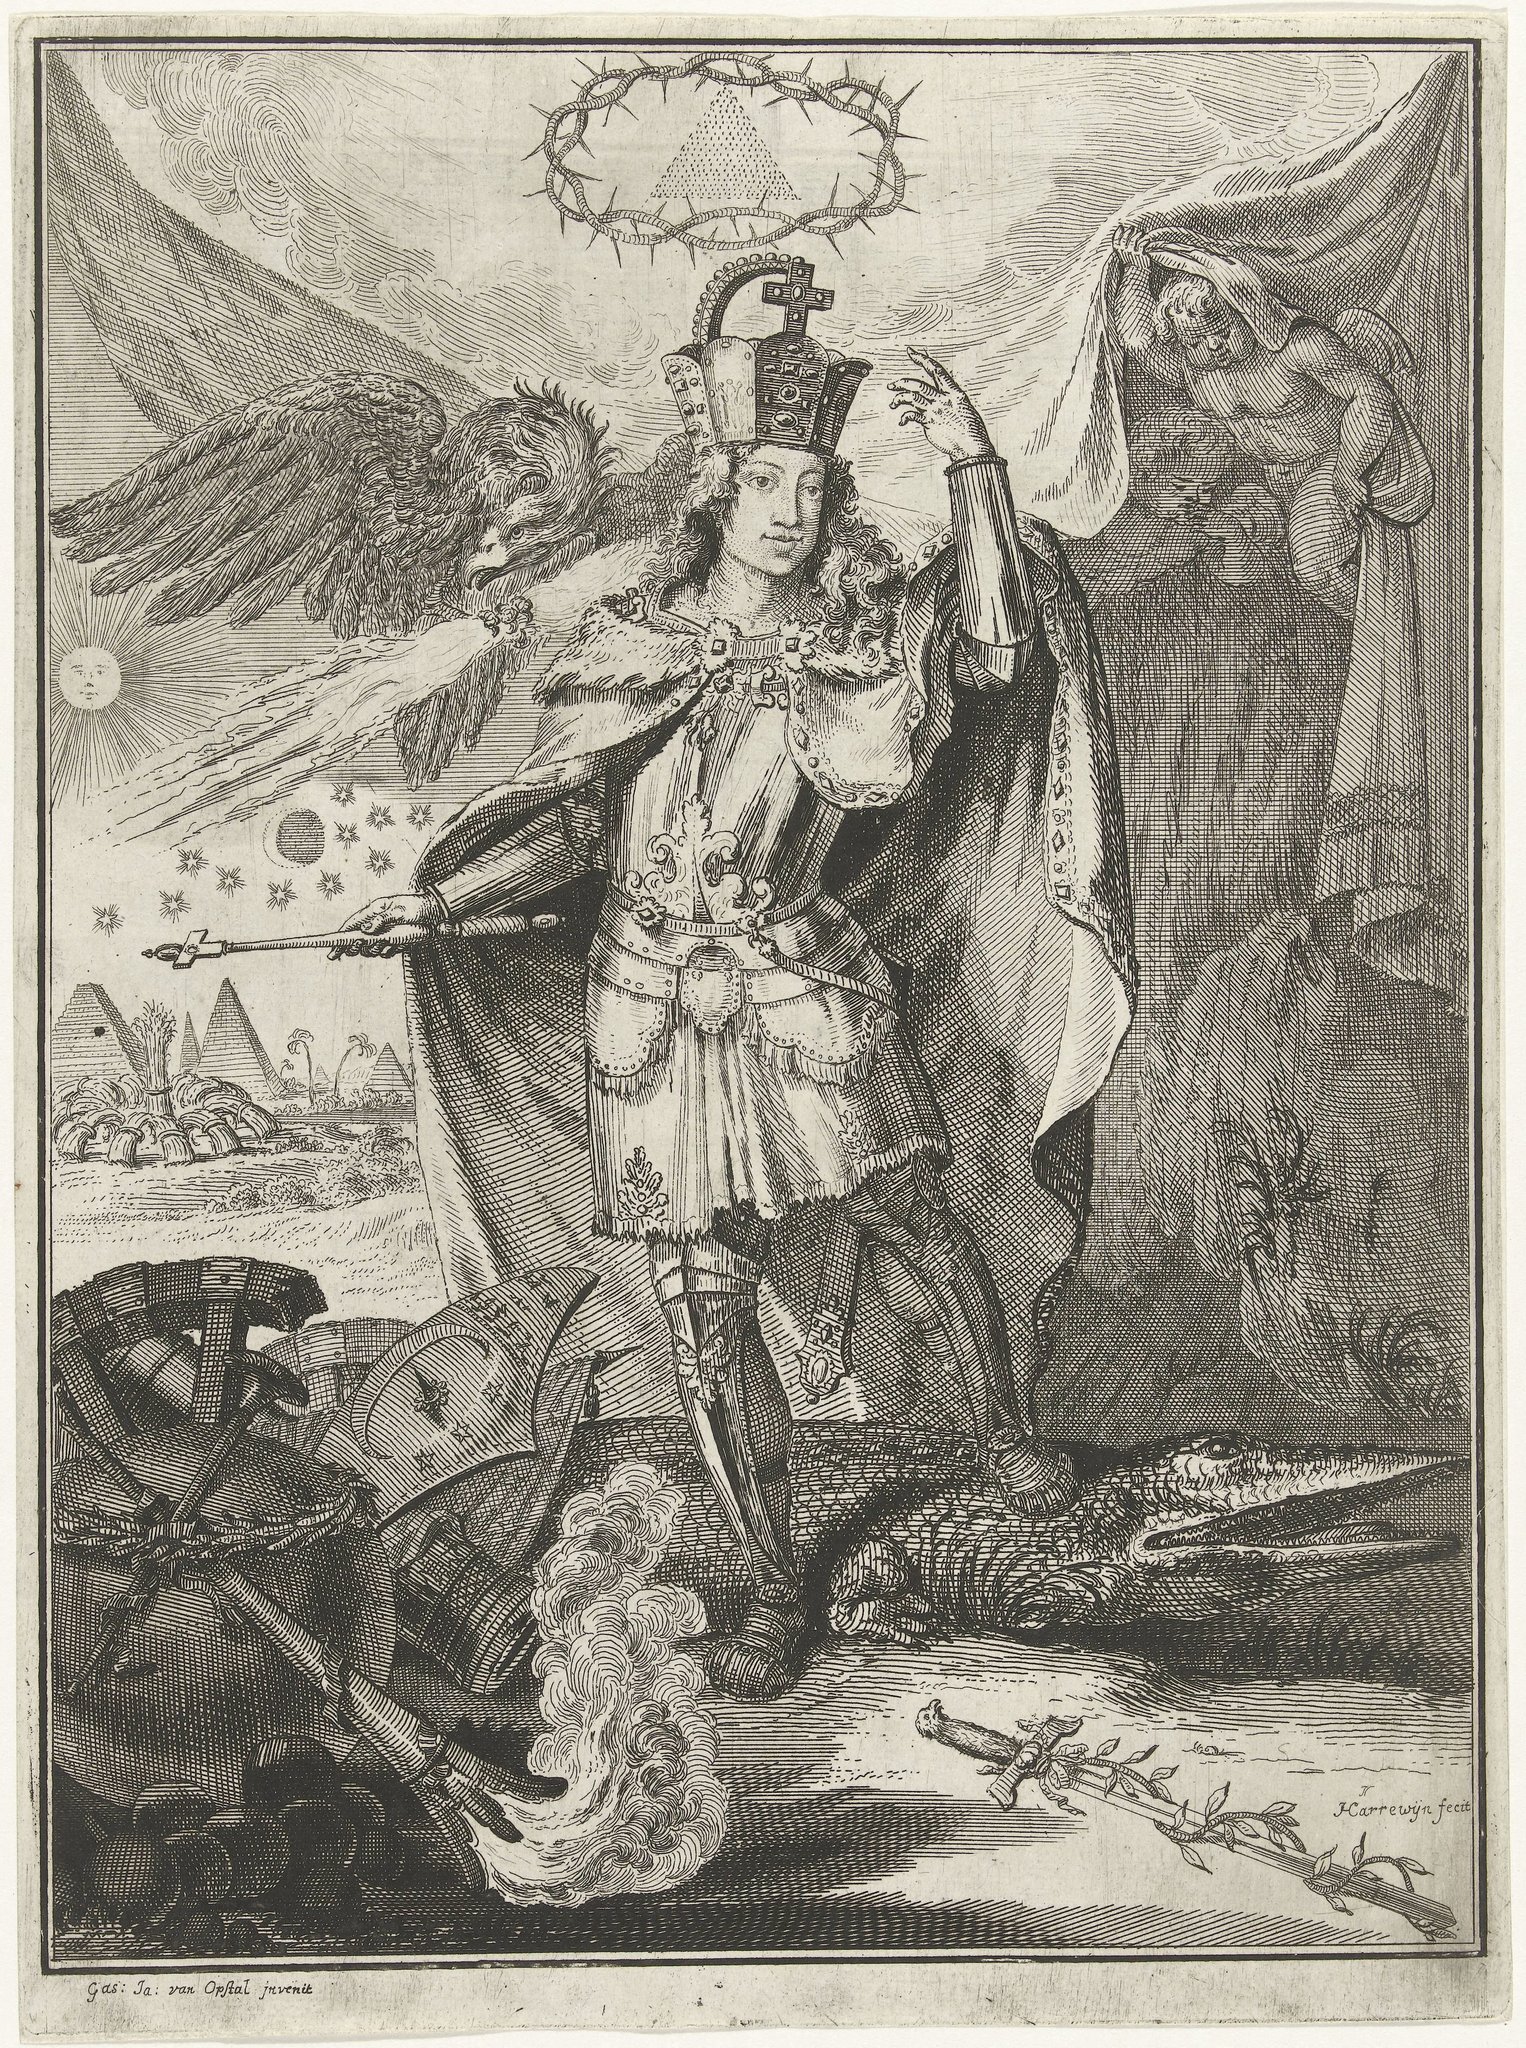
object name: print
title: Figuur in harnas met kroon en scepter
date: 1682-1730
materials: paper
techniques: engraving, etching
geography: low countries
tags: crown of thorns ~ instruments of the passion, homage to a ruler, symbols of the trinity ~ circular and/or triangular forms or arrangements, insignia and symbols of sovereignty (crown, diadem, sceptre, orb, seal, standard, cloak, pectoral)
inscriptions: collector's mark: Lugt 2228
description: Ferdinand IV van Oostenrijk, keizer van het Heilige Roomse Rijk, in harnas en met kroon en scepter, met zijn linkervoet op een krokodil. Op de achtergrond een adelaar met een bliksemschicht en putti onder een gordijn. Boven zijn portret een doornenkrans en het ideogram van een gelijkzijdige driehoek als symbool voor de heilige Drieëenheid.